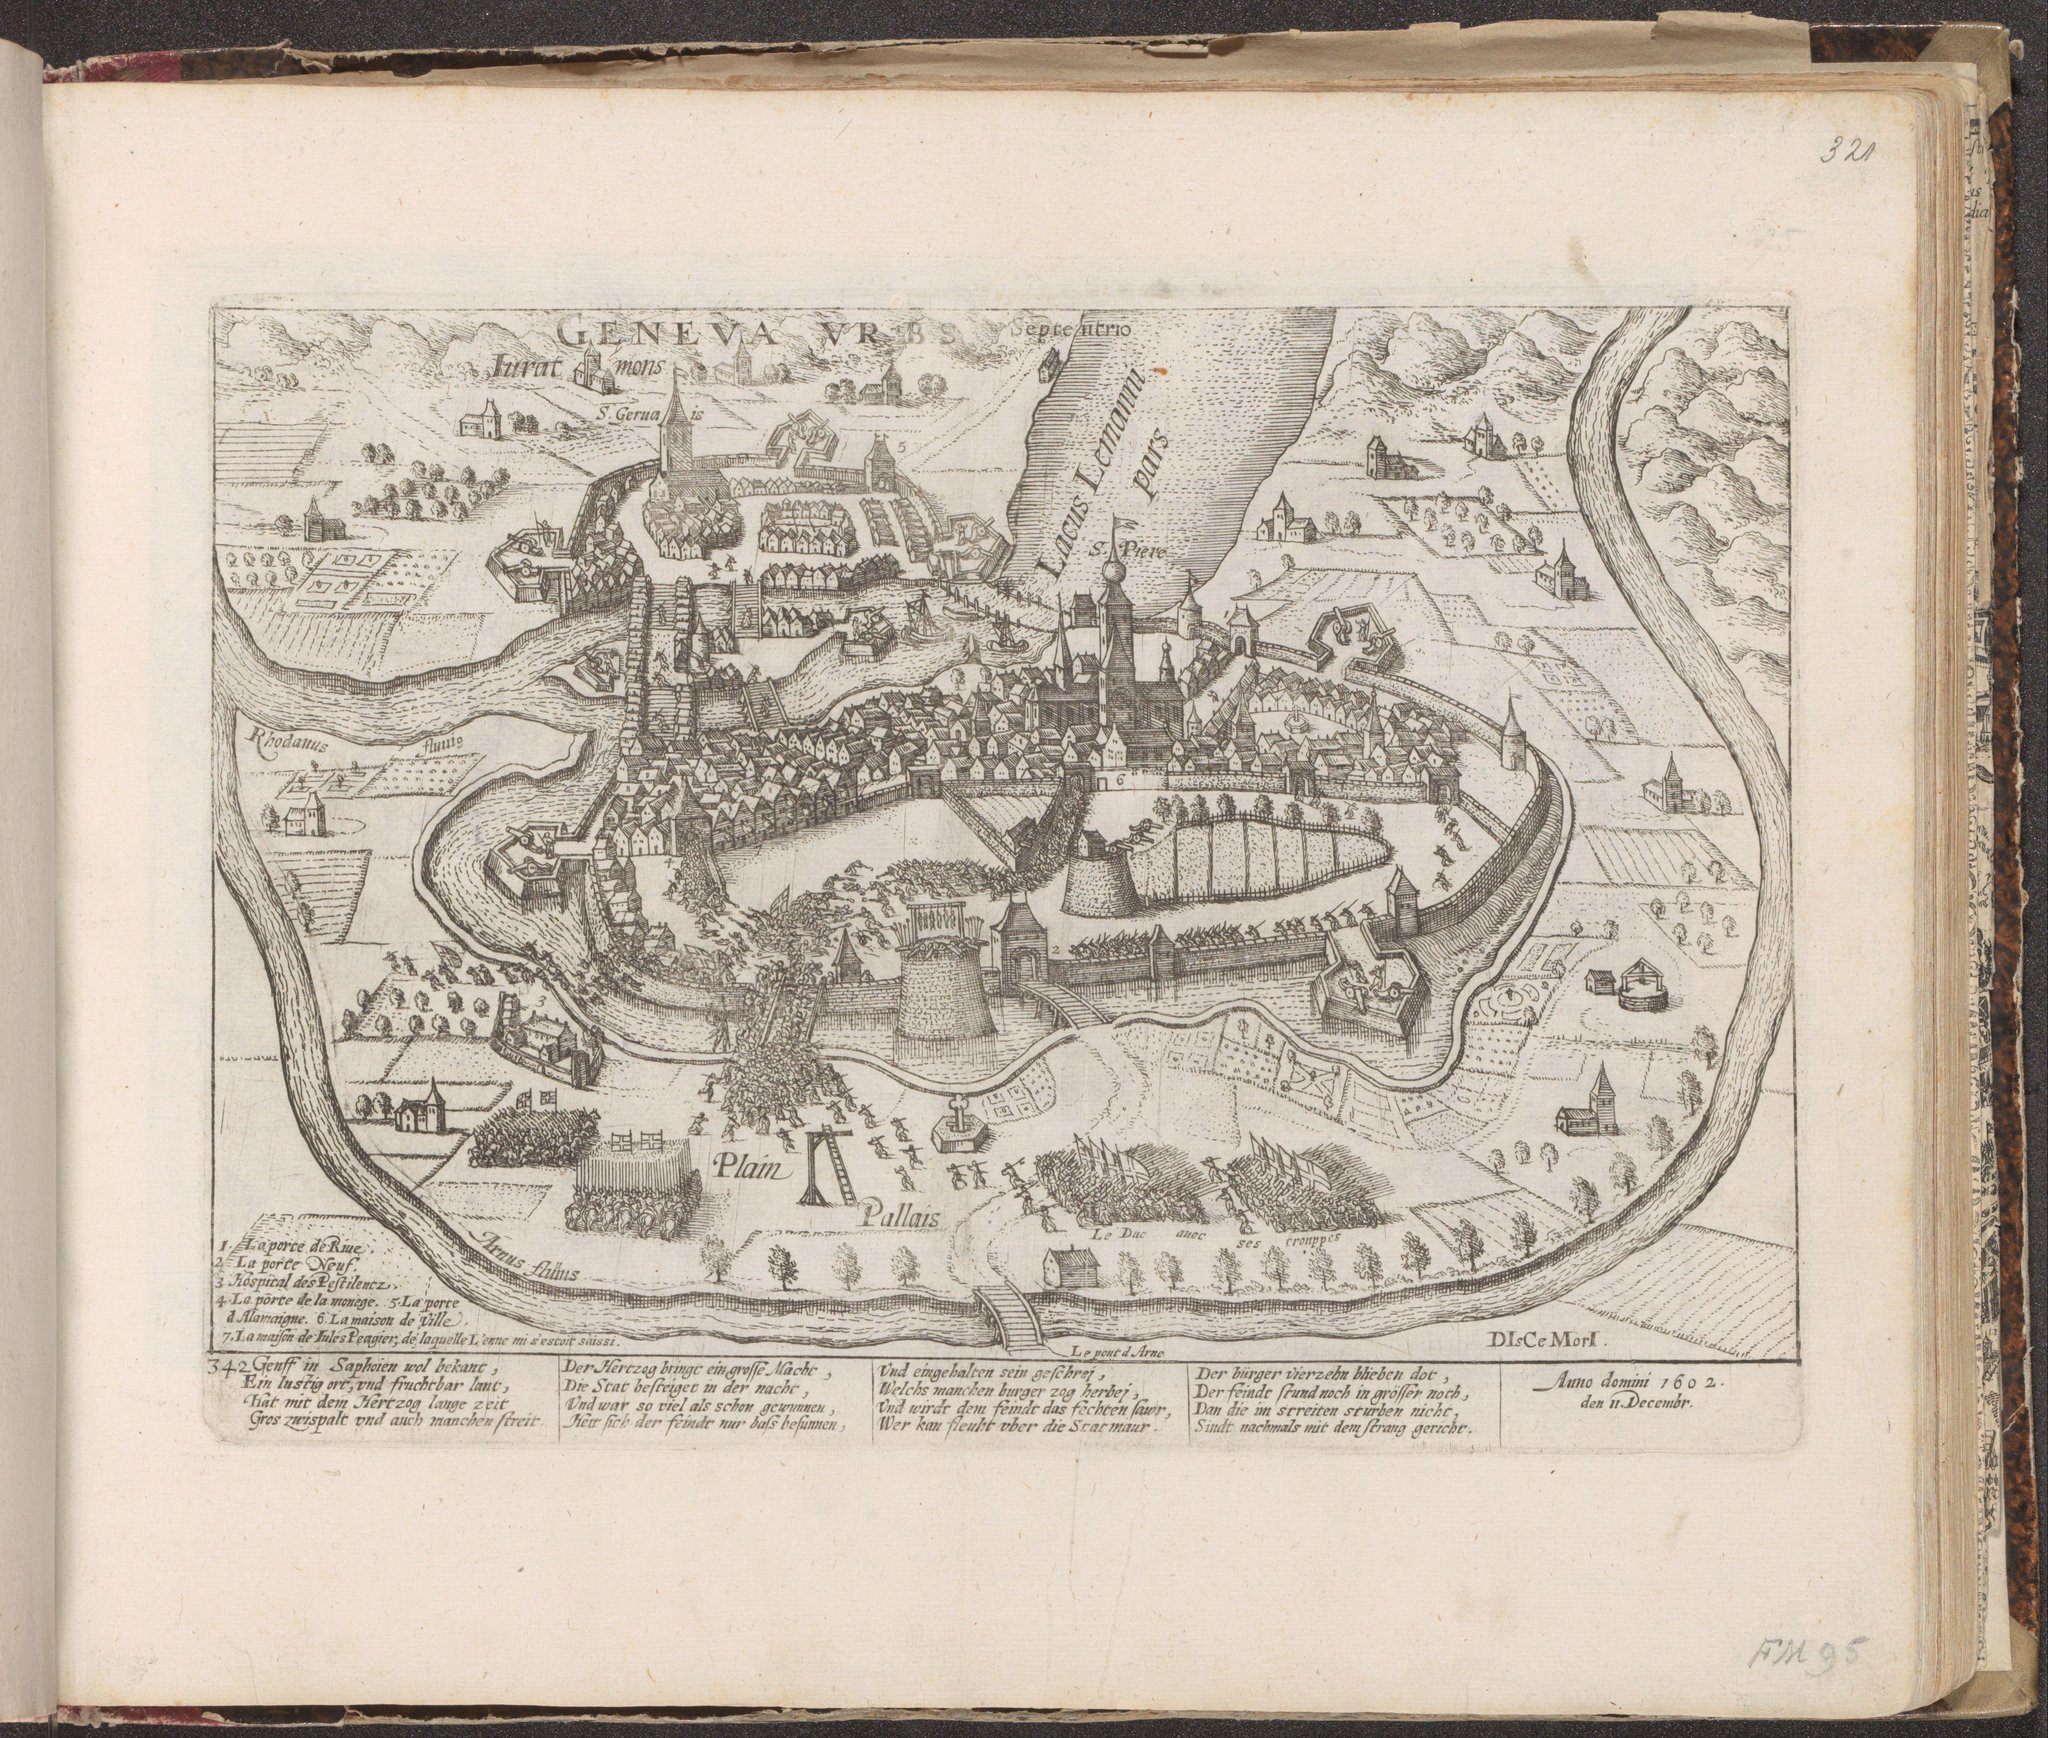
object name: print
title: Serie 4: Franse, Duitse en Engelse Gebeurtenissen, 1576-1610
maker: frans hogenberg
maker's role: print maker, publisher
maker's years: 1538-1590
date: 1602-1604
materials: paper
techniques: engraving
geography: cologne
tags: attack ~ siege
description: Mislukte aanval op Genève door de hertog van Savoije, 11 december 1602. Met onderschrift van 16 regels in het Duits en een legenda in het Frans. Linksonder genummerd: 342. De prent maakt deel uit van een album.